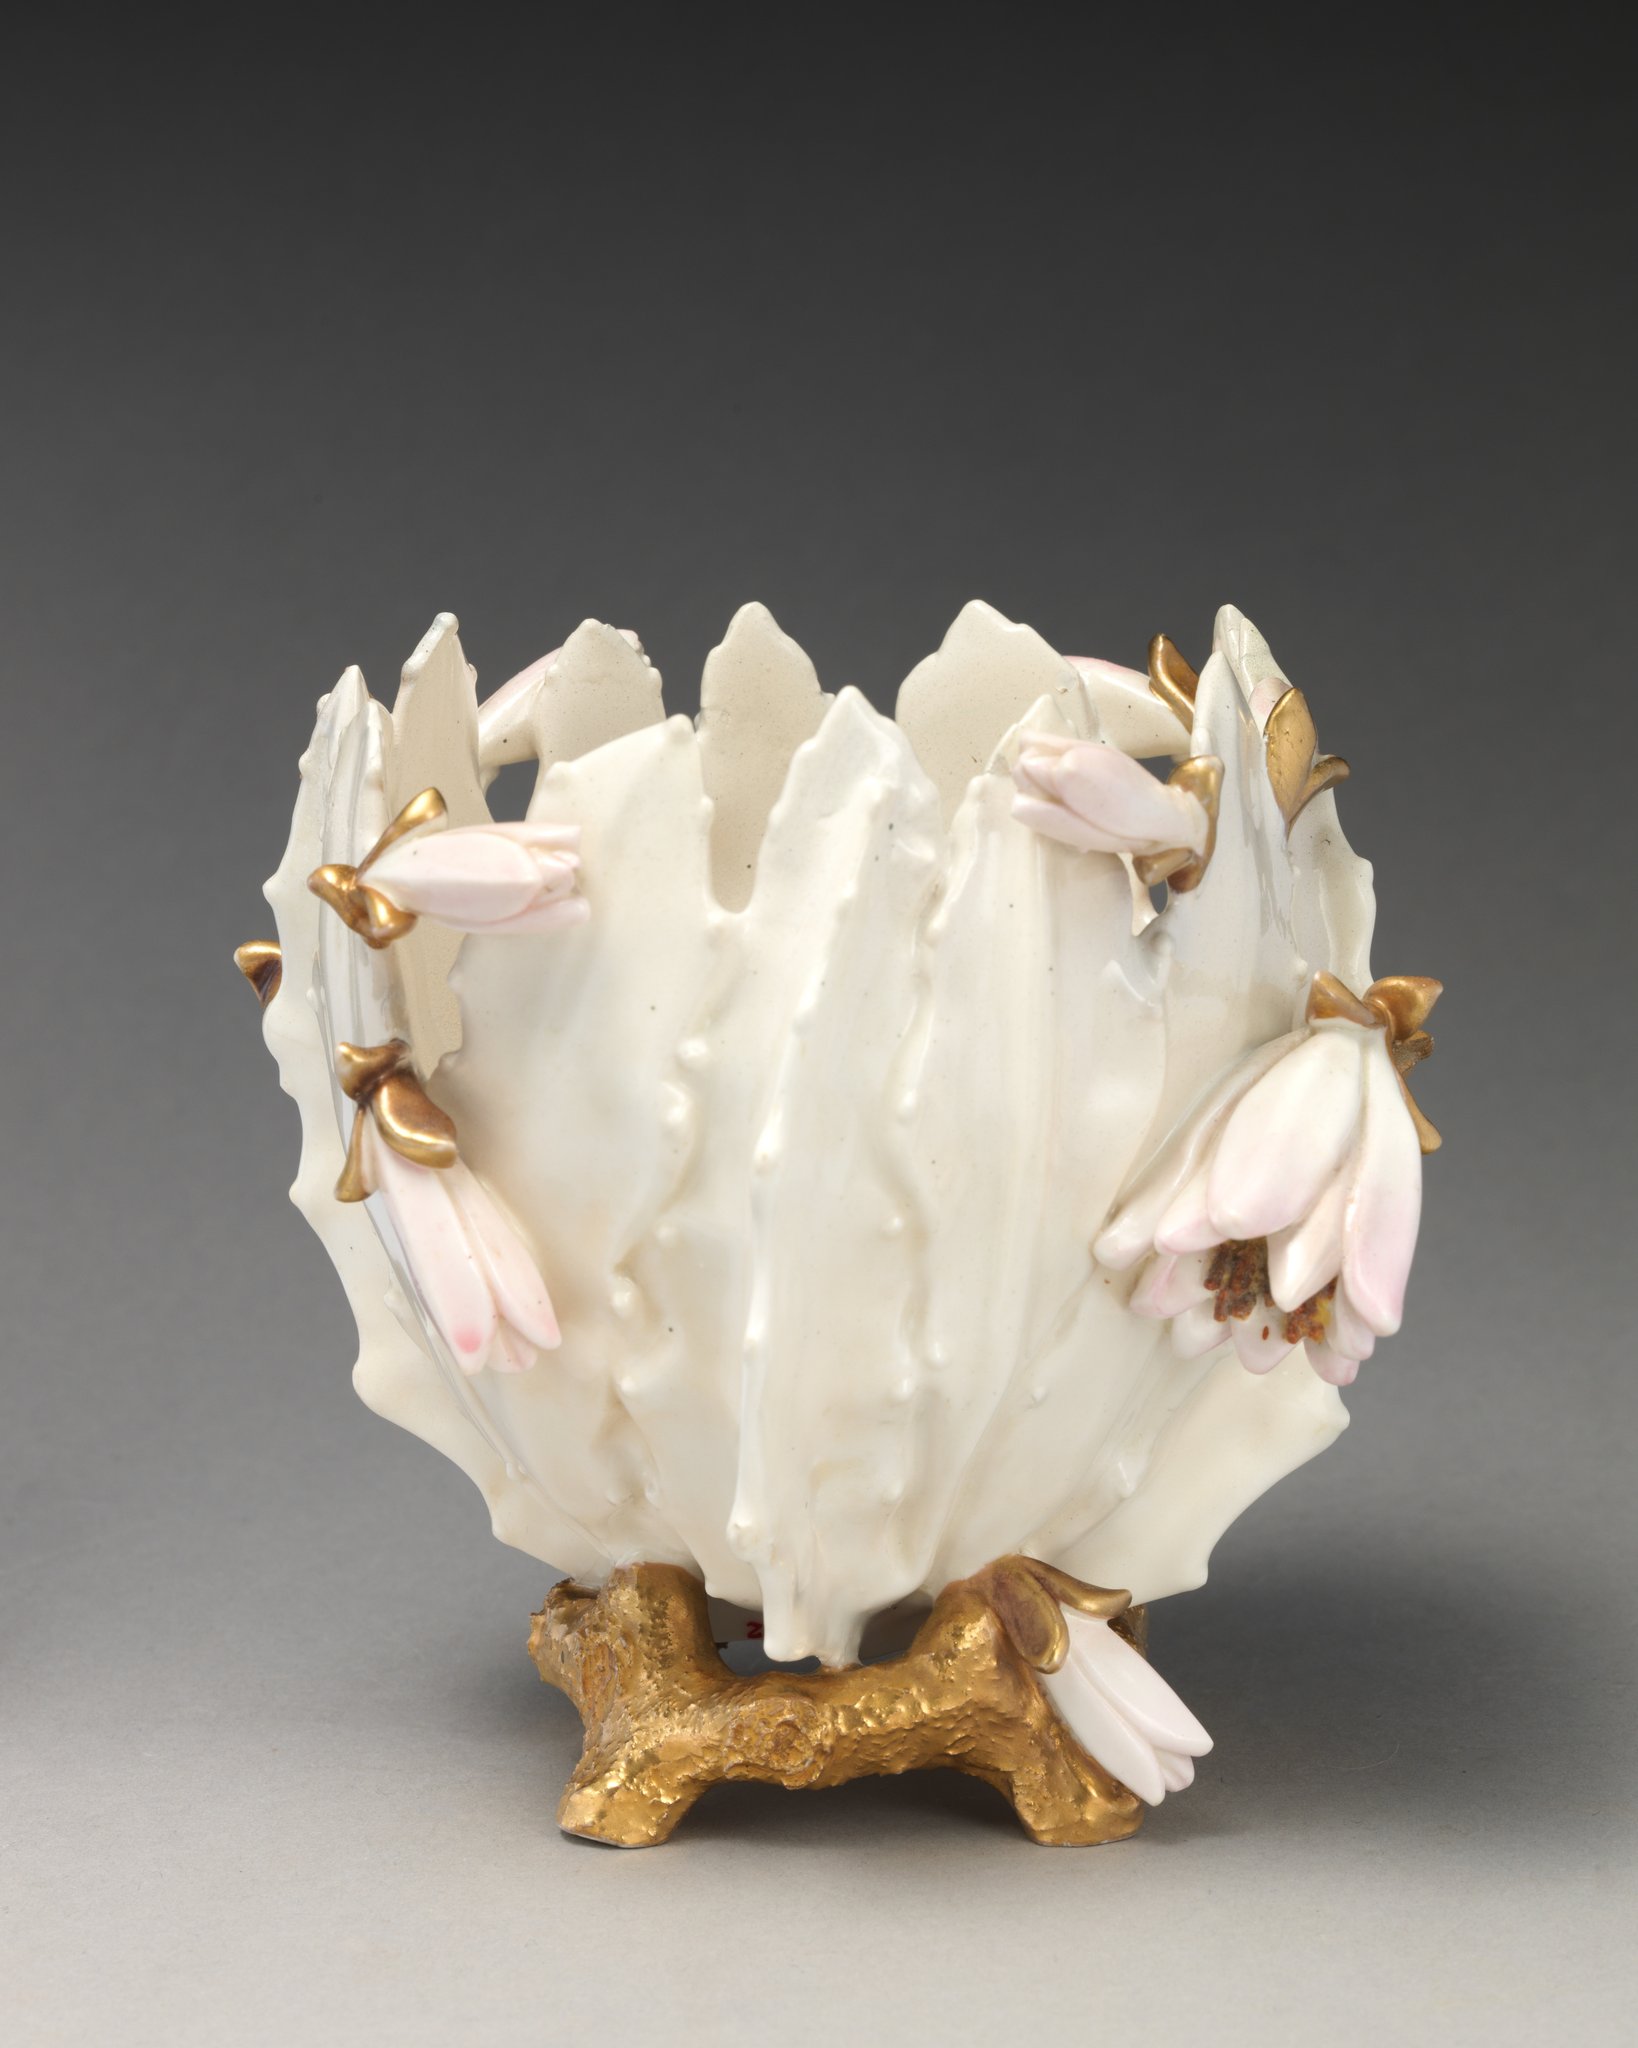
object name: bowl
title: Cactus flower vase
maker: moore brothers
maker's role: maker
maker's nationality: british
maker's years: 1870-1905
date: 1870-1880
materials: bone china, enamel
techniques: gilding